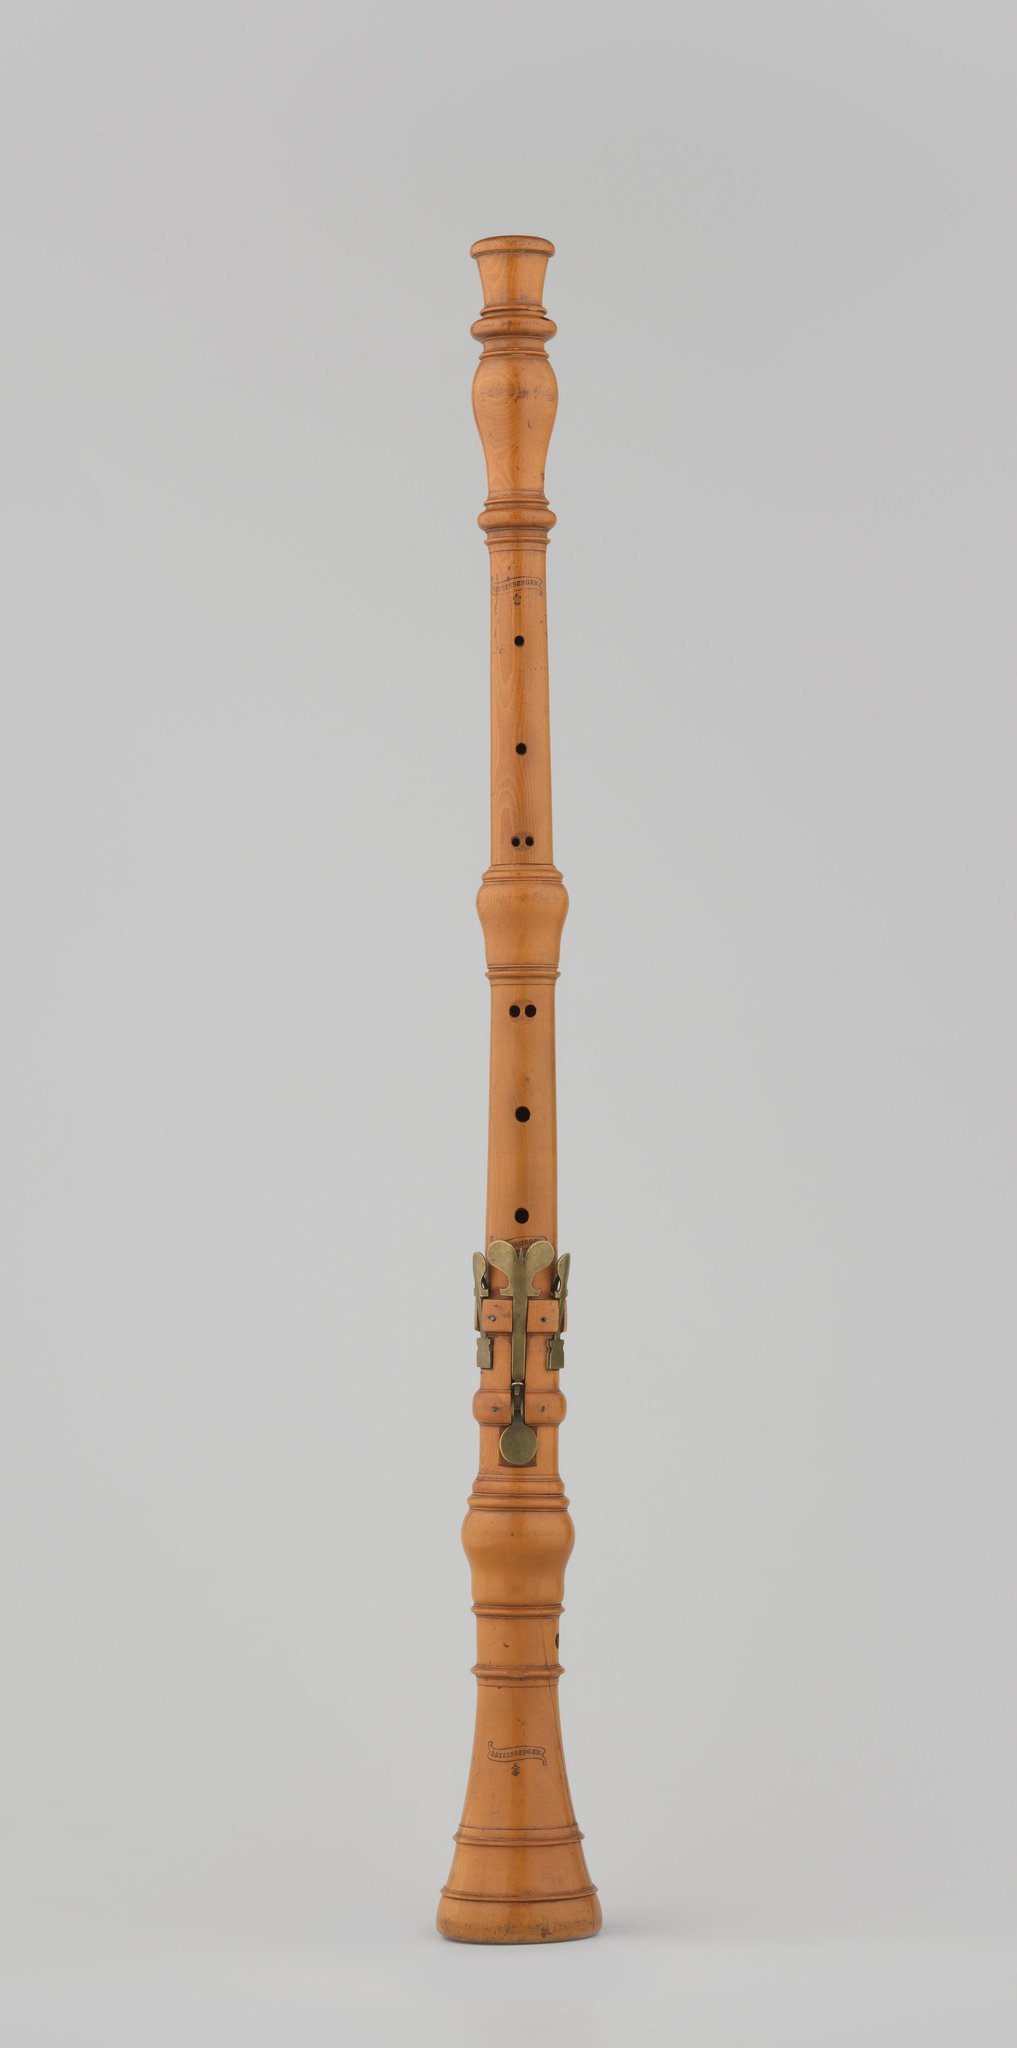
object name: musical instrument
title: Oboe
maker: jan steenbergen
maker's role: musical instrument maker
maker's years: 1676-1730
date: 1700-1730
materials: wood, brass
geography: amsterdam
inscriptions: inscription: ‘I : STEENBERGEN (in een rol) / [fleur de lis]’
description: Hobo van palmhout met drie messing kleppen. Het derde en vierde gat zijn dubbel. Er zitten twee gaten in de beker. Gemarkeerd op alle delen: I : STEENBERGEN (in een rol) / [fleur de lis].